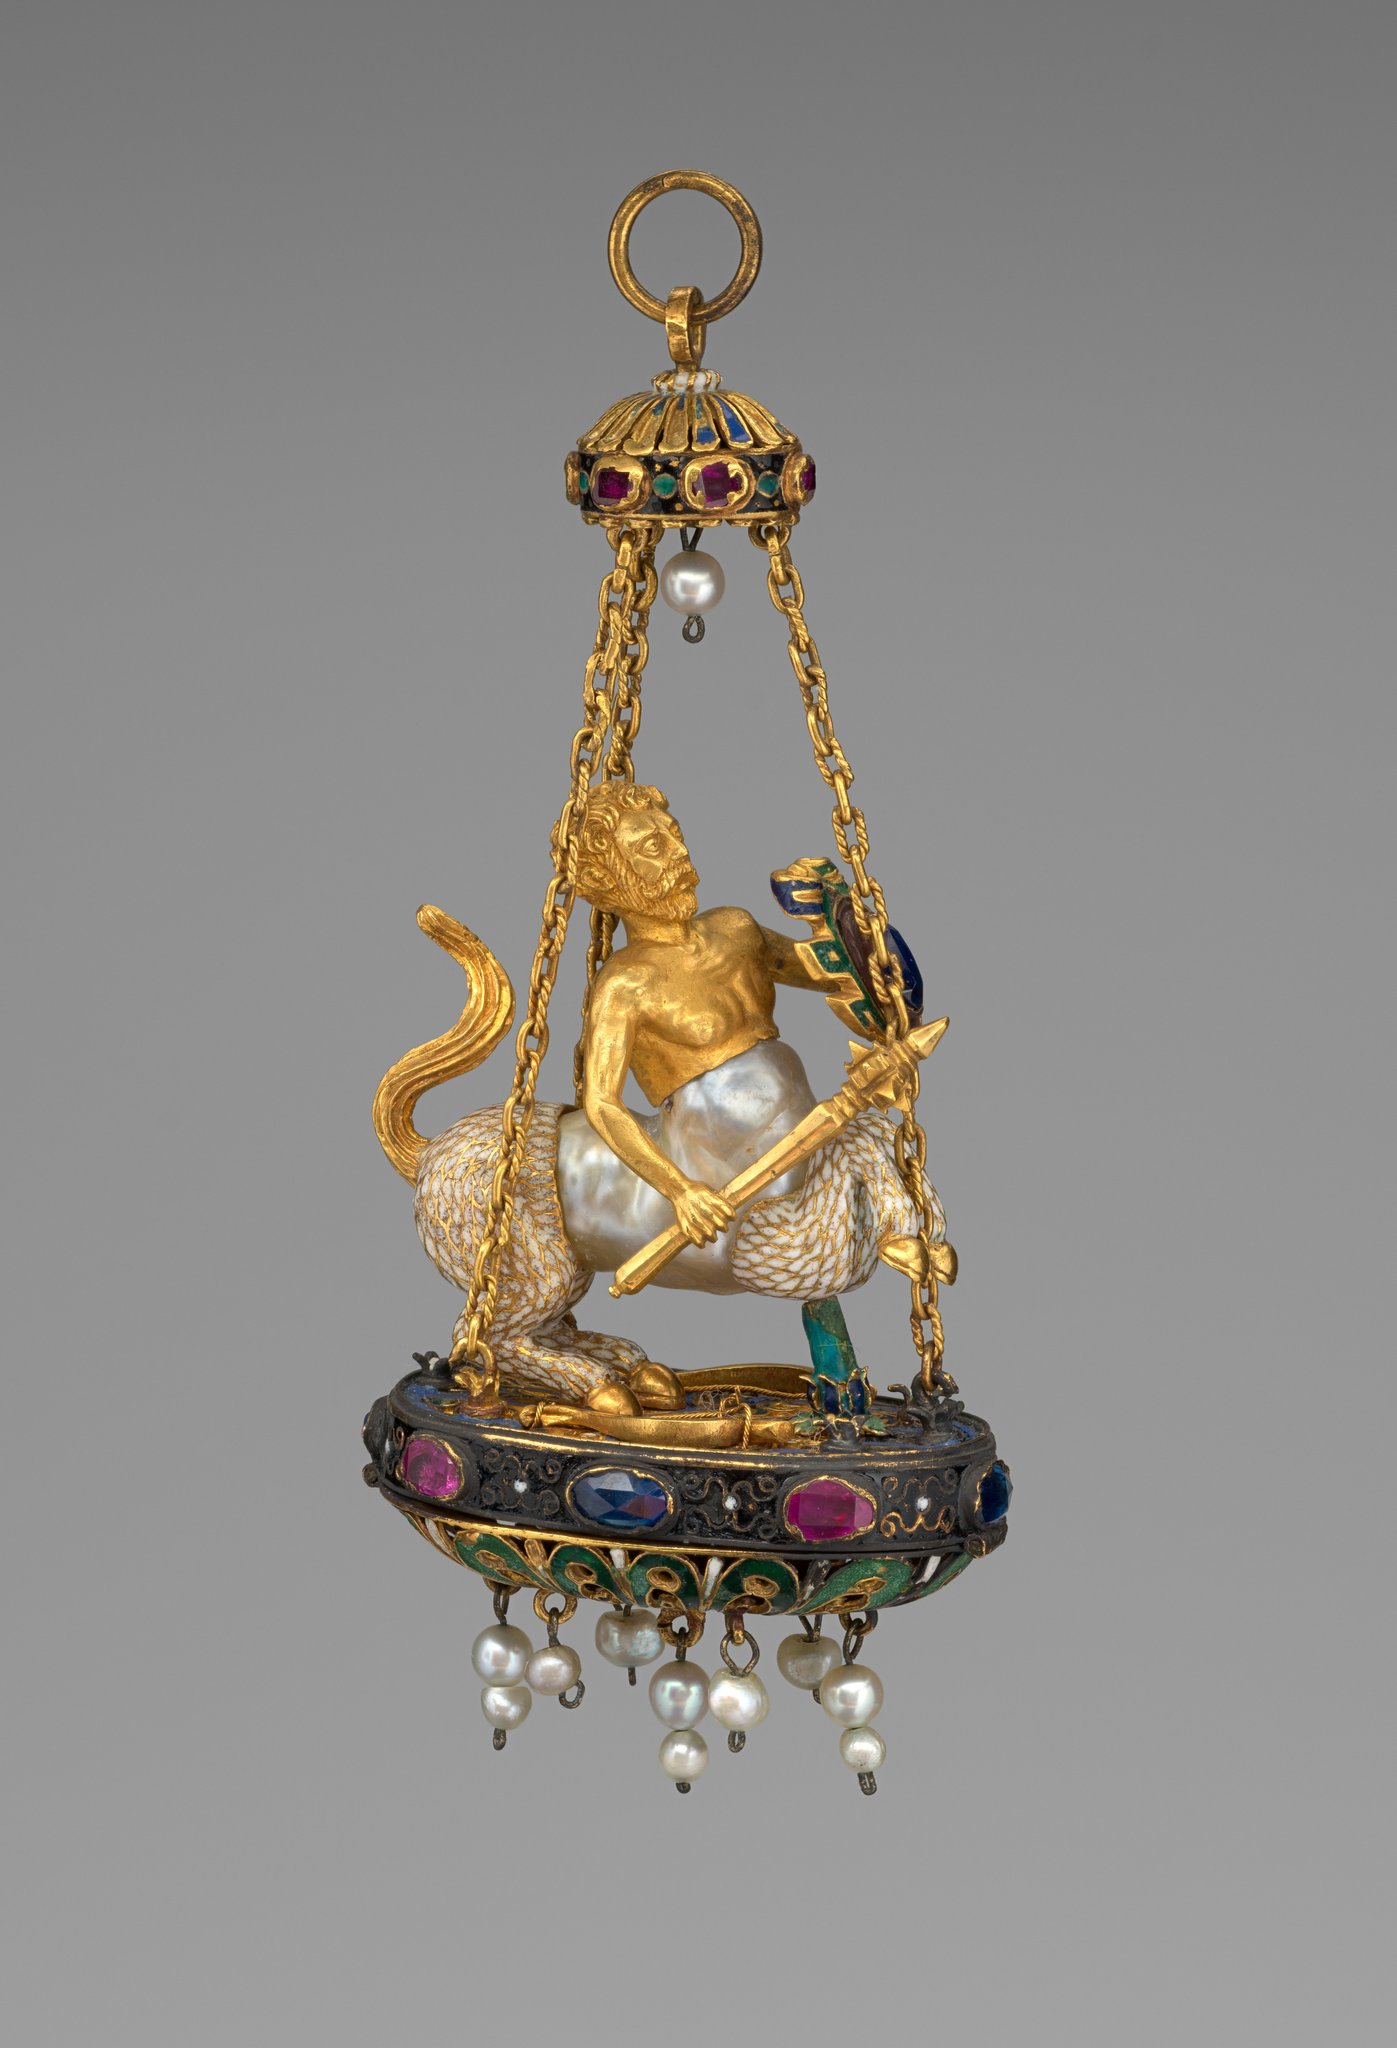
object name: pendant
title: Pendant in the form of a centaur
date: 1567-1633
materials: gold, pearl, gemstone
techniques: enamel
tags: centaurs